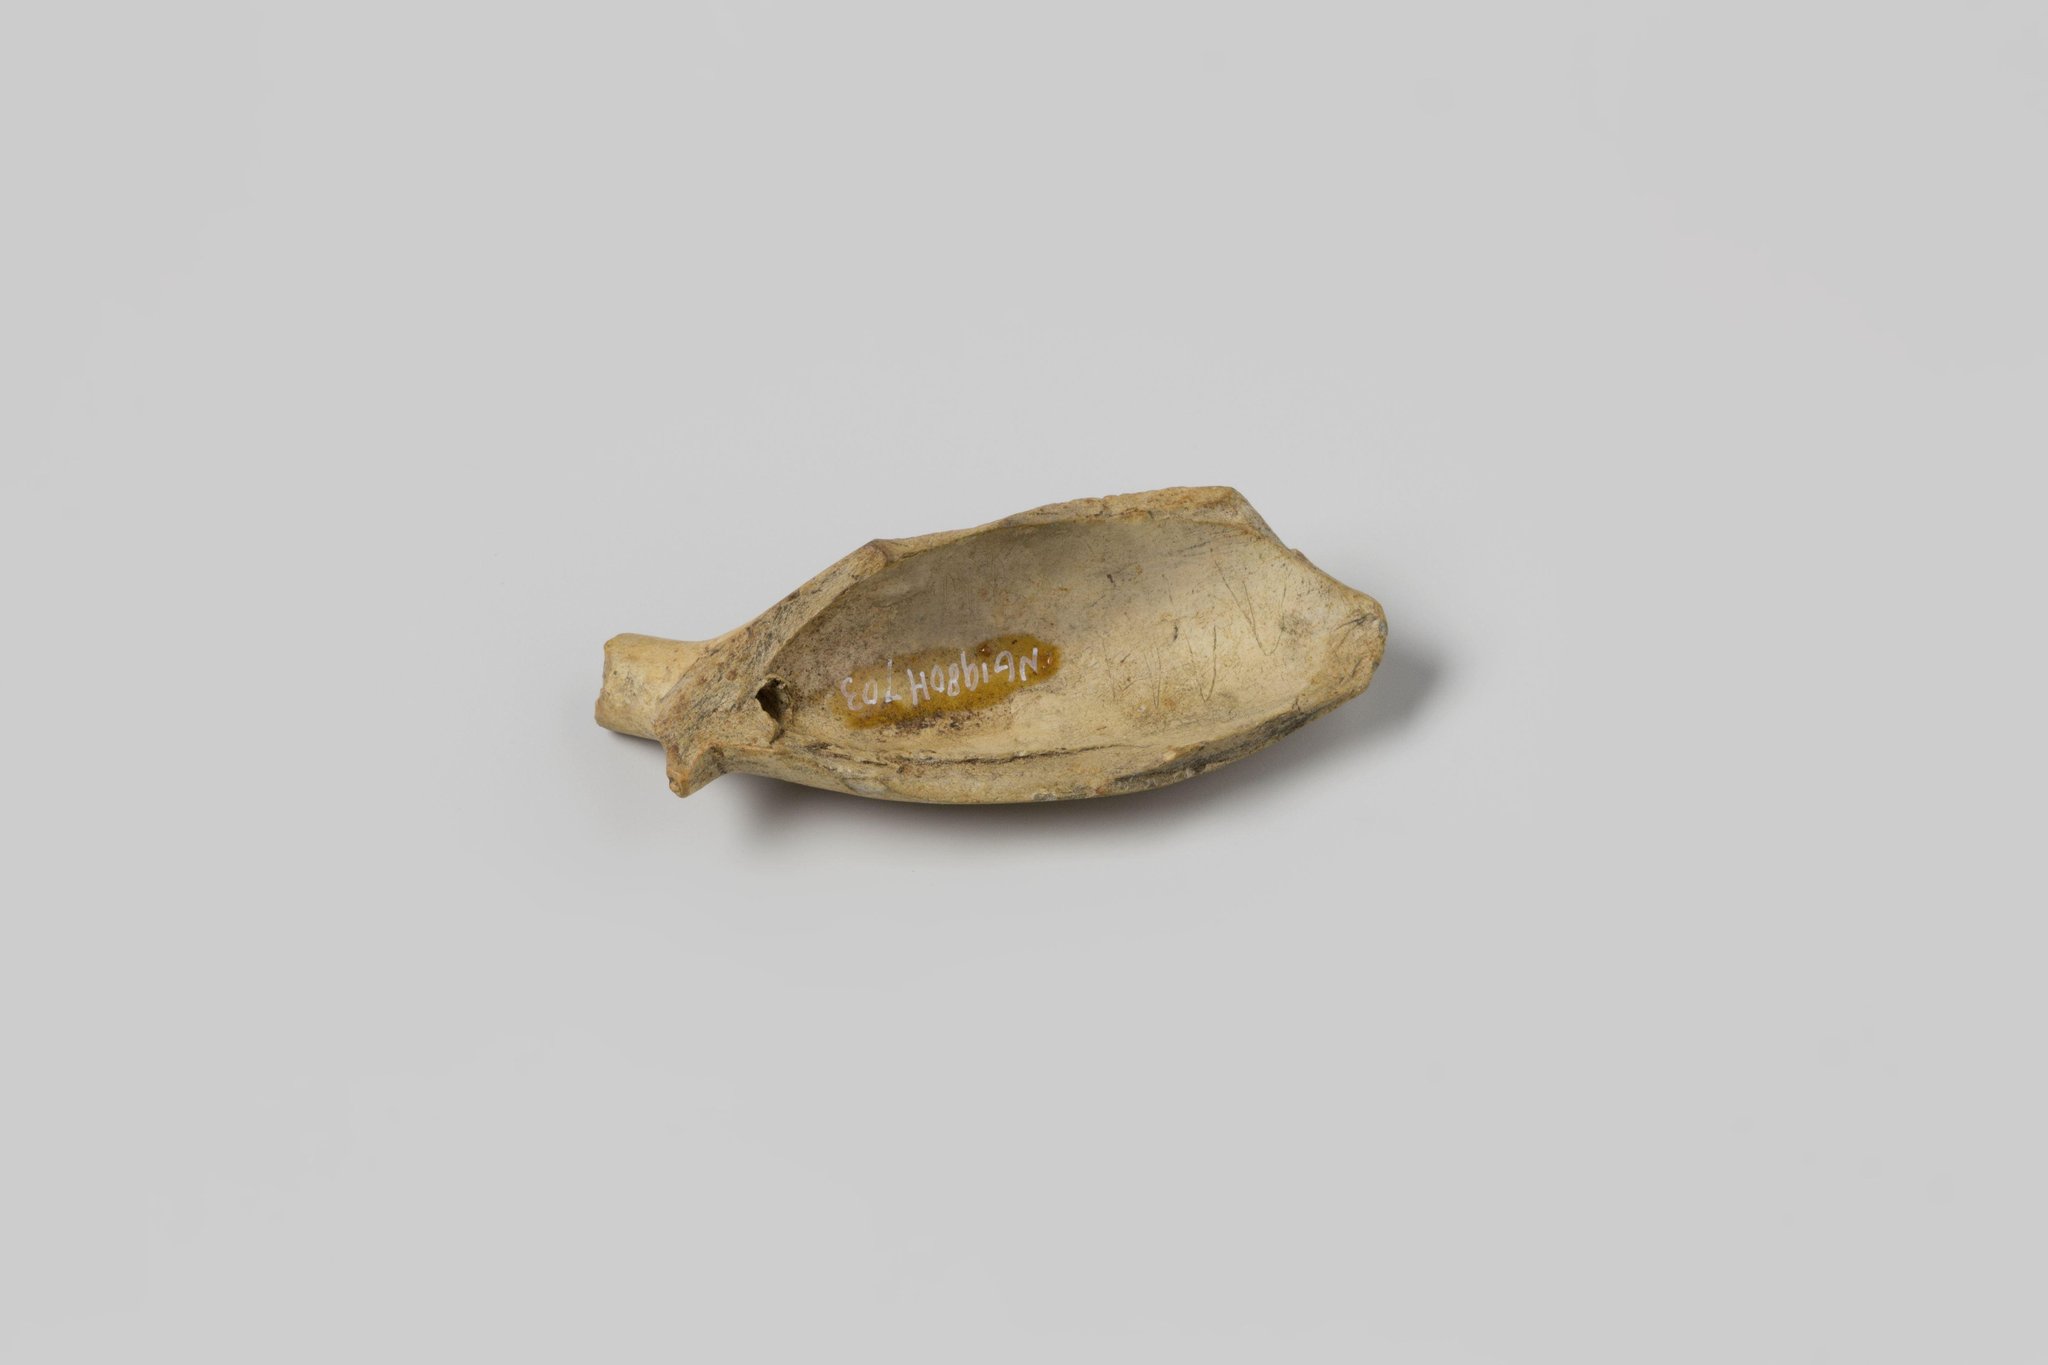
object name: pipe bowl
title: Fragment pijpenkop uit het wrak van de Oost-Indiëvaarder Hollandia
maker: Anonymous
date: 1700-1743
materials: clay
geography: netherlands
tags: verenigde oostindische compagnie, hollandia (schip), annet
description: Pipe, bowl, heelmark illegible; fragment, no hsm.